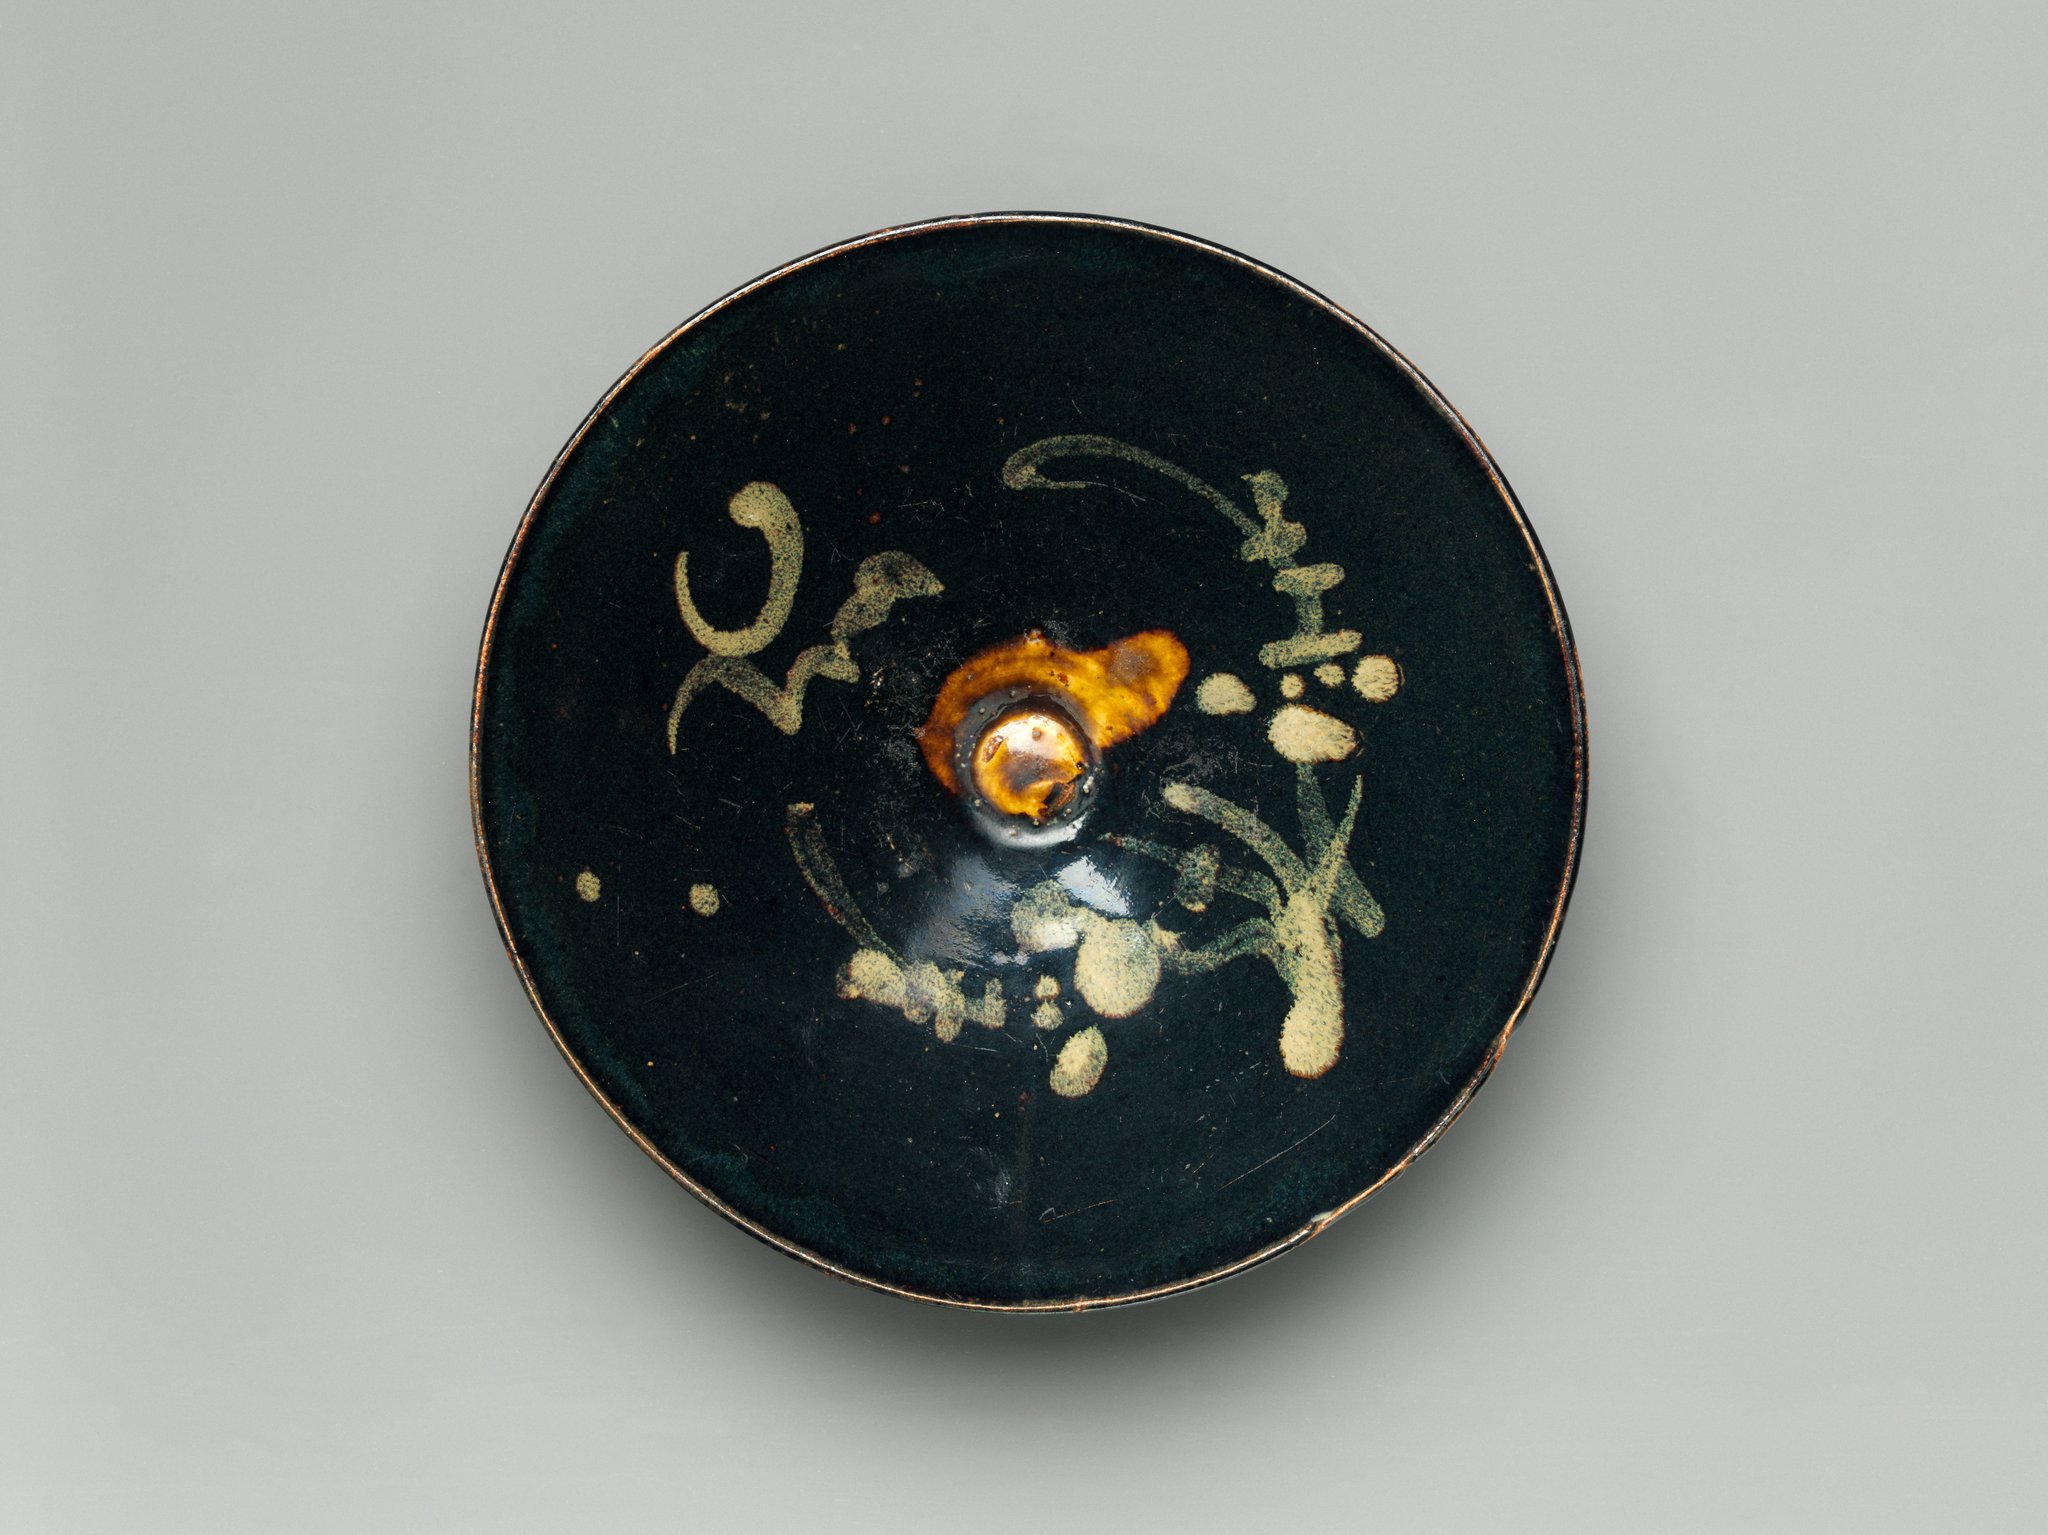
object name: teabowl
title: Tea Bowl with Crescent Moon, Clouds, and Blossoming Plums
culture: japanese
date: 1601-1700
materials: glaze, stoneware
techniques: painting